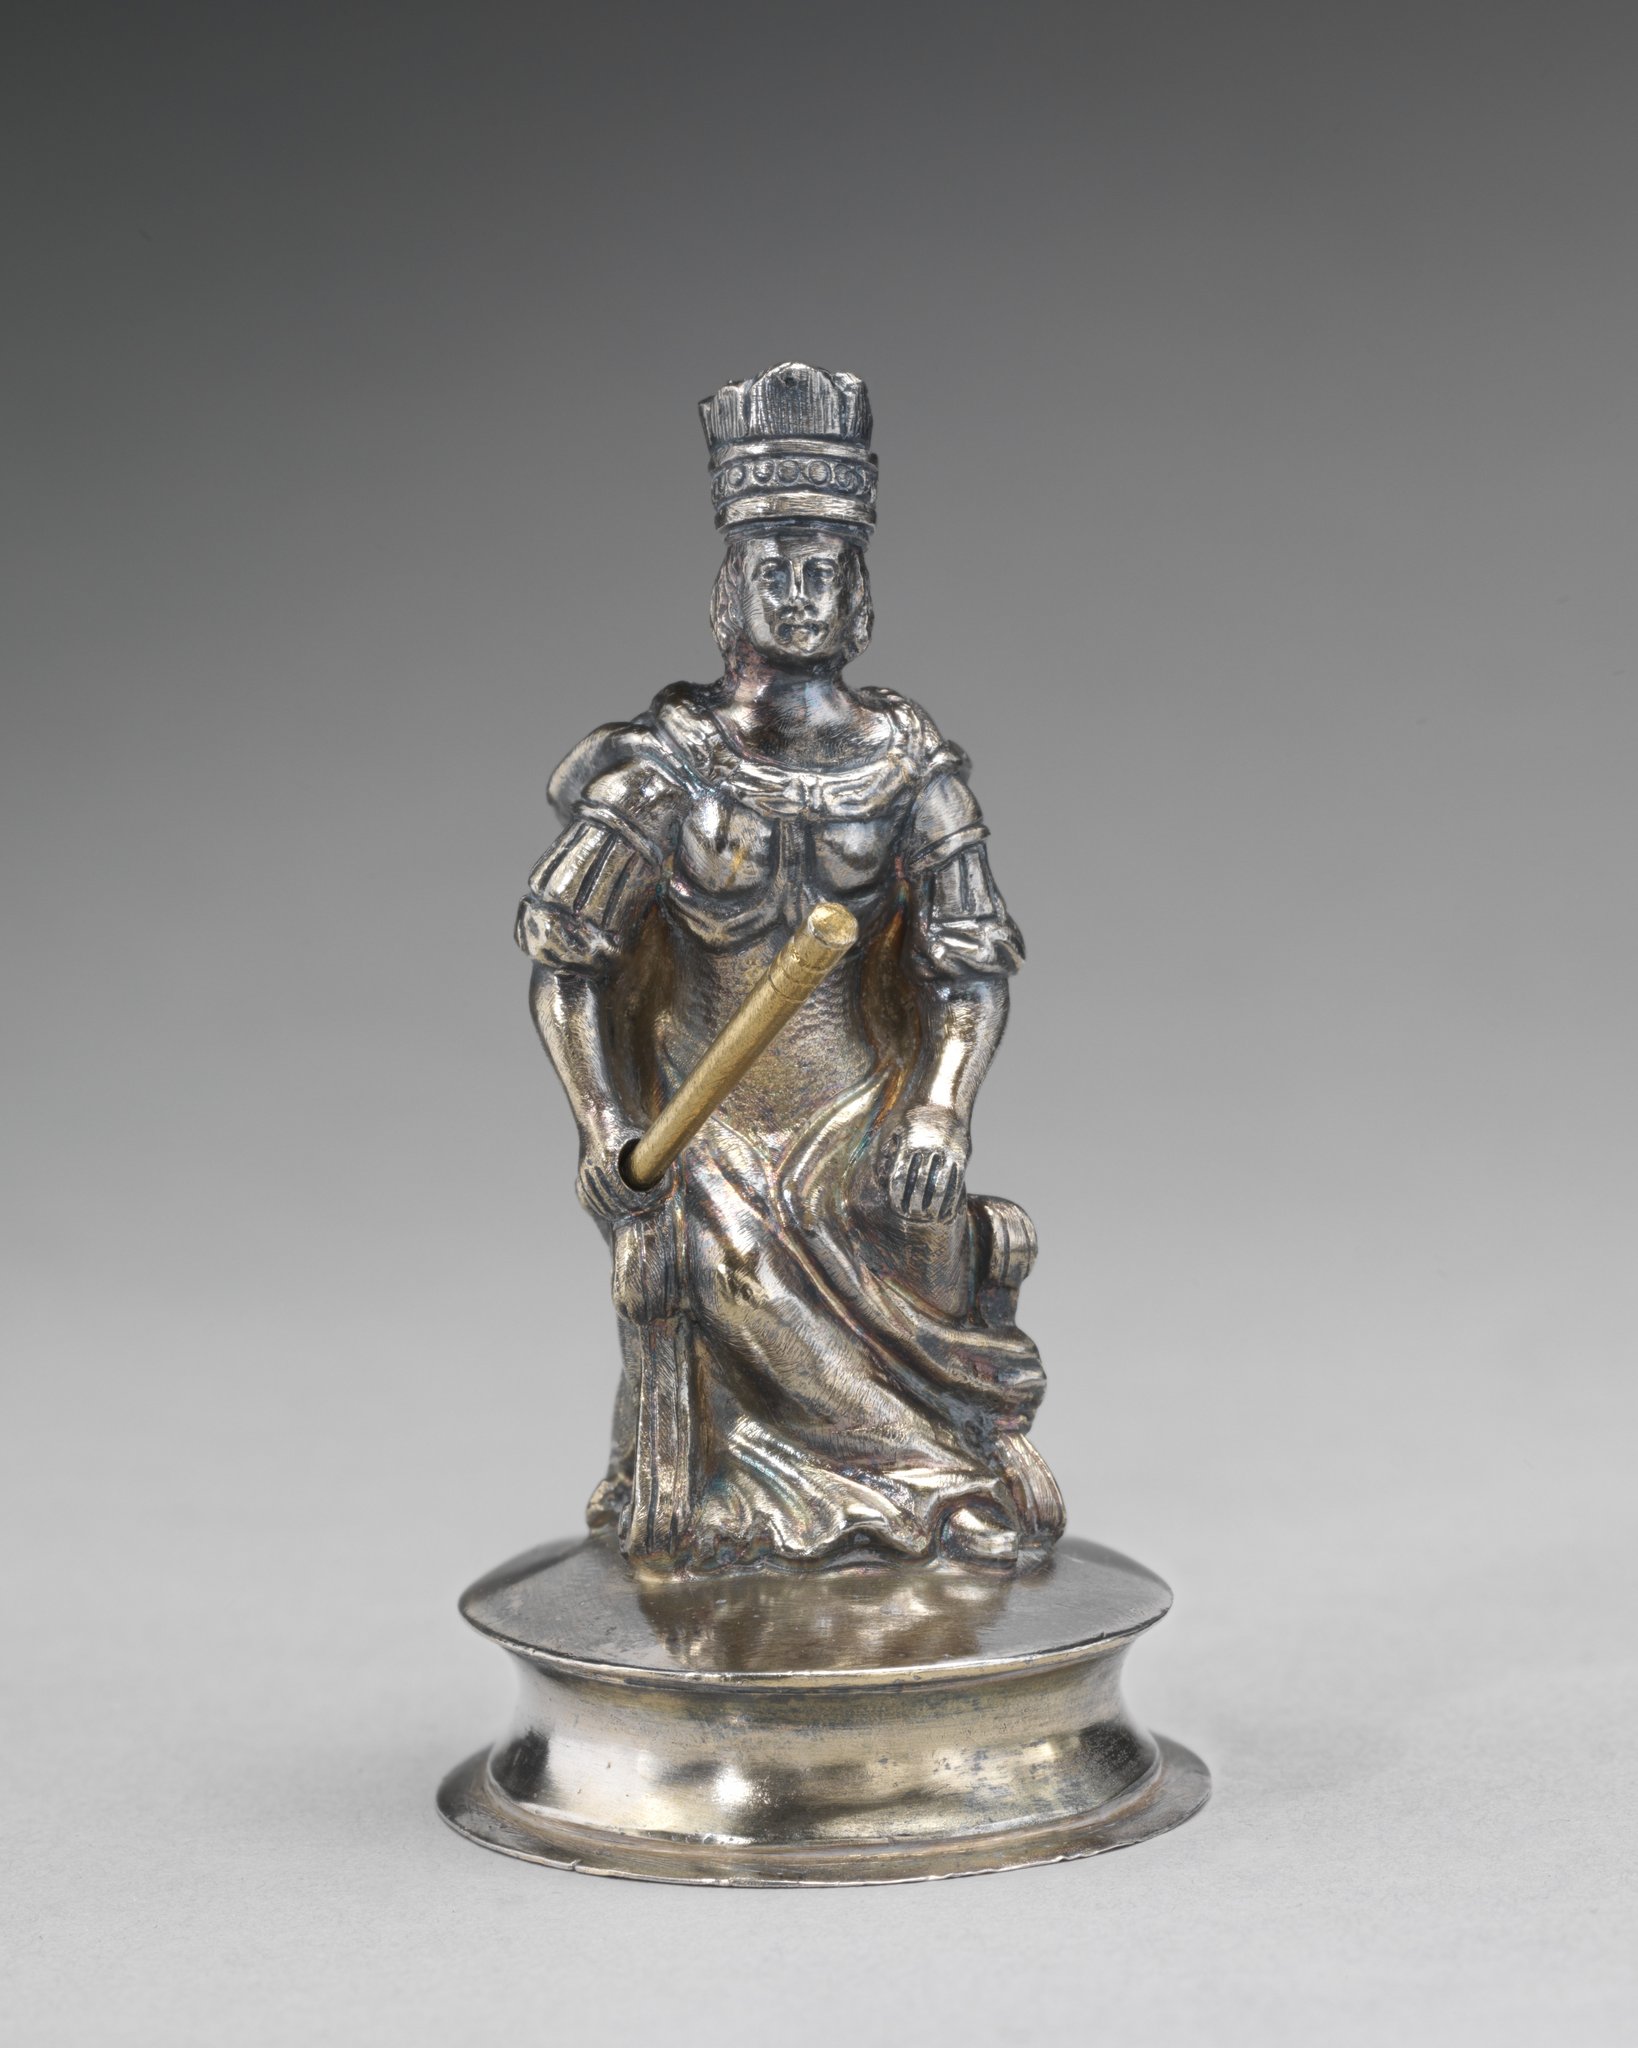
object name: chessman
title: Chessman (Queen)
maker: elkington & co.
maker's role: manufacturer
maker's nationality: british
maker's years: 1829-1963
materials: silver gilt